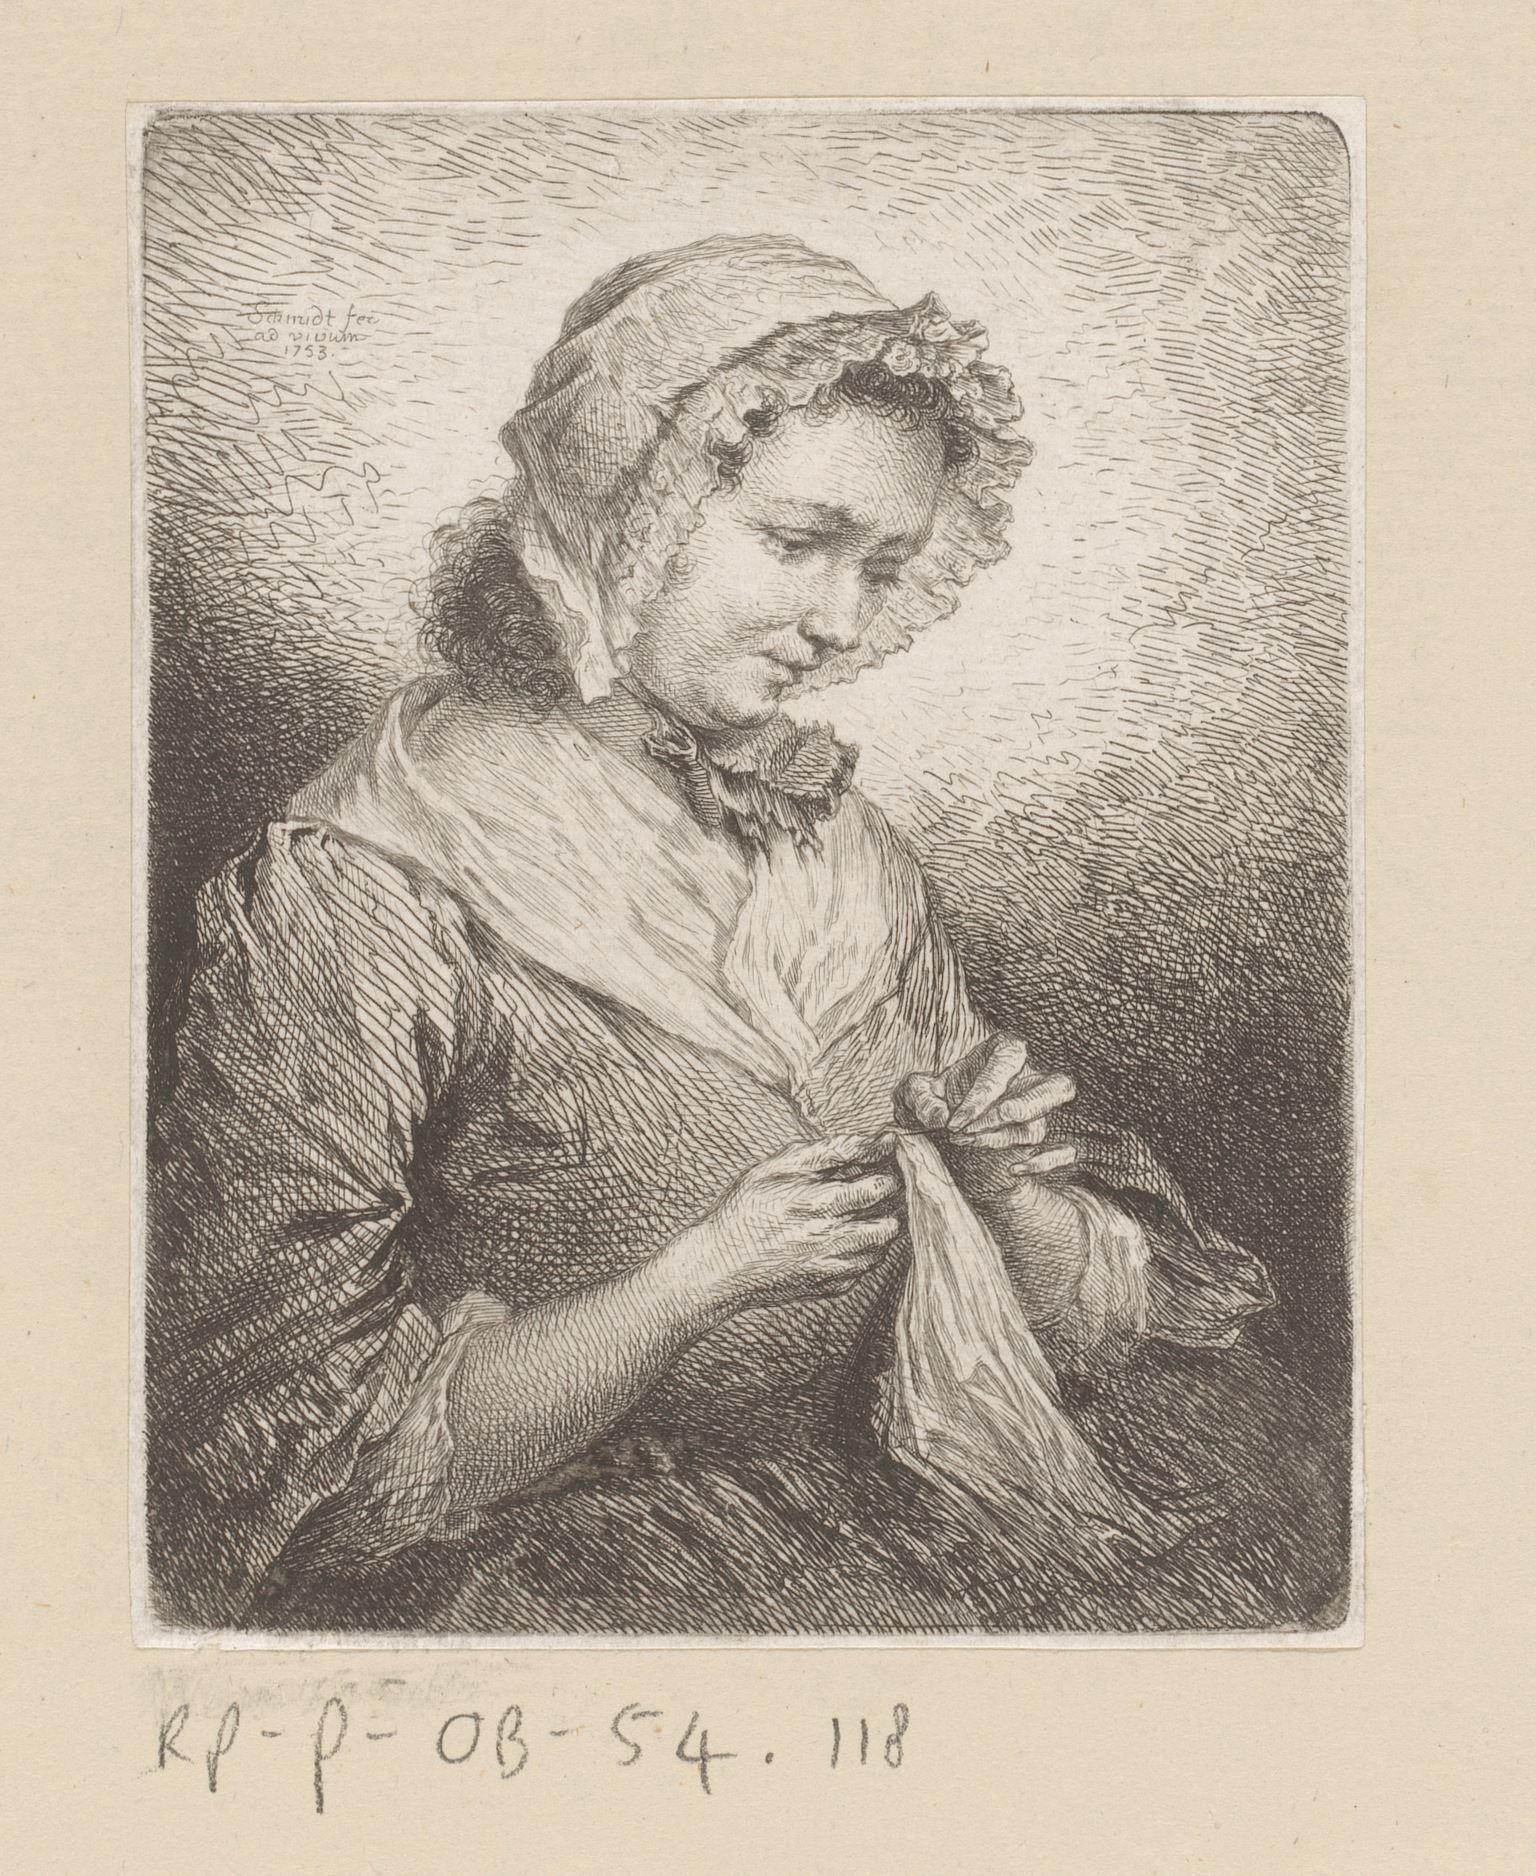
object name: print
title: Portret van Dorothea Louise Schmidt naaiend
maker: georg friedrich schmidt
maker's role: draughtsman, print maker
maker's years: 1712-1775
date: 1753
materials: paper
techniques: etching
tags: historical persons - bb - woman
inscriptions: collector's mark: Lugt 240